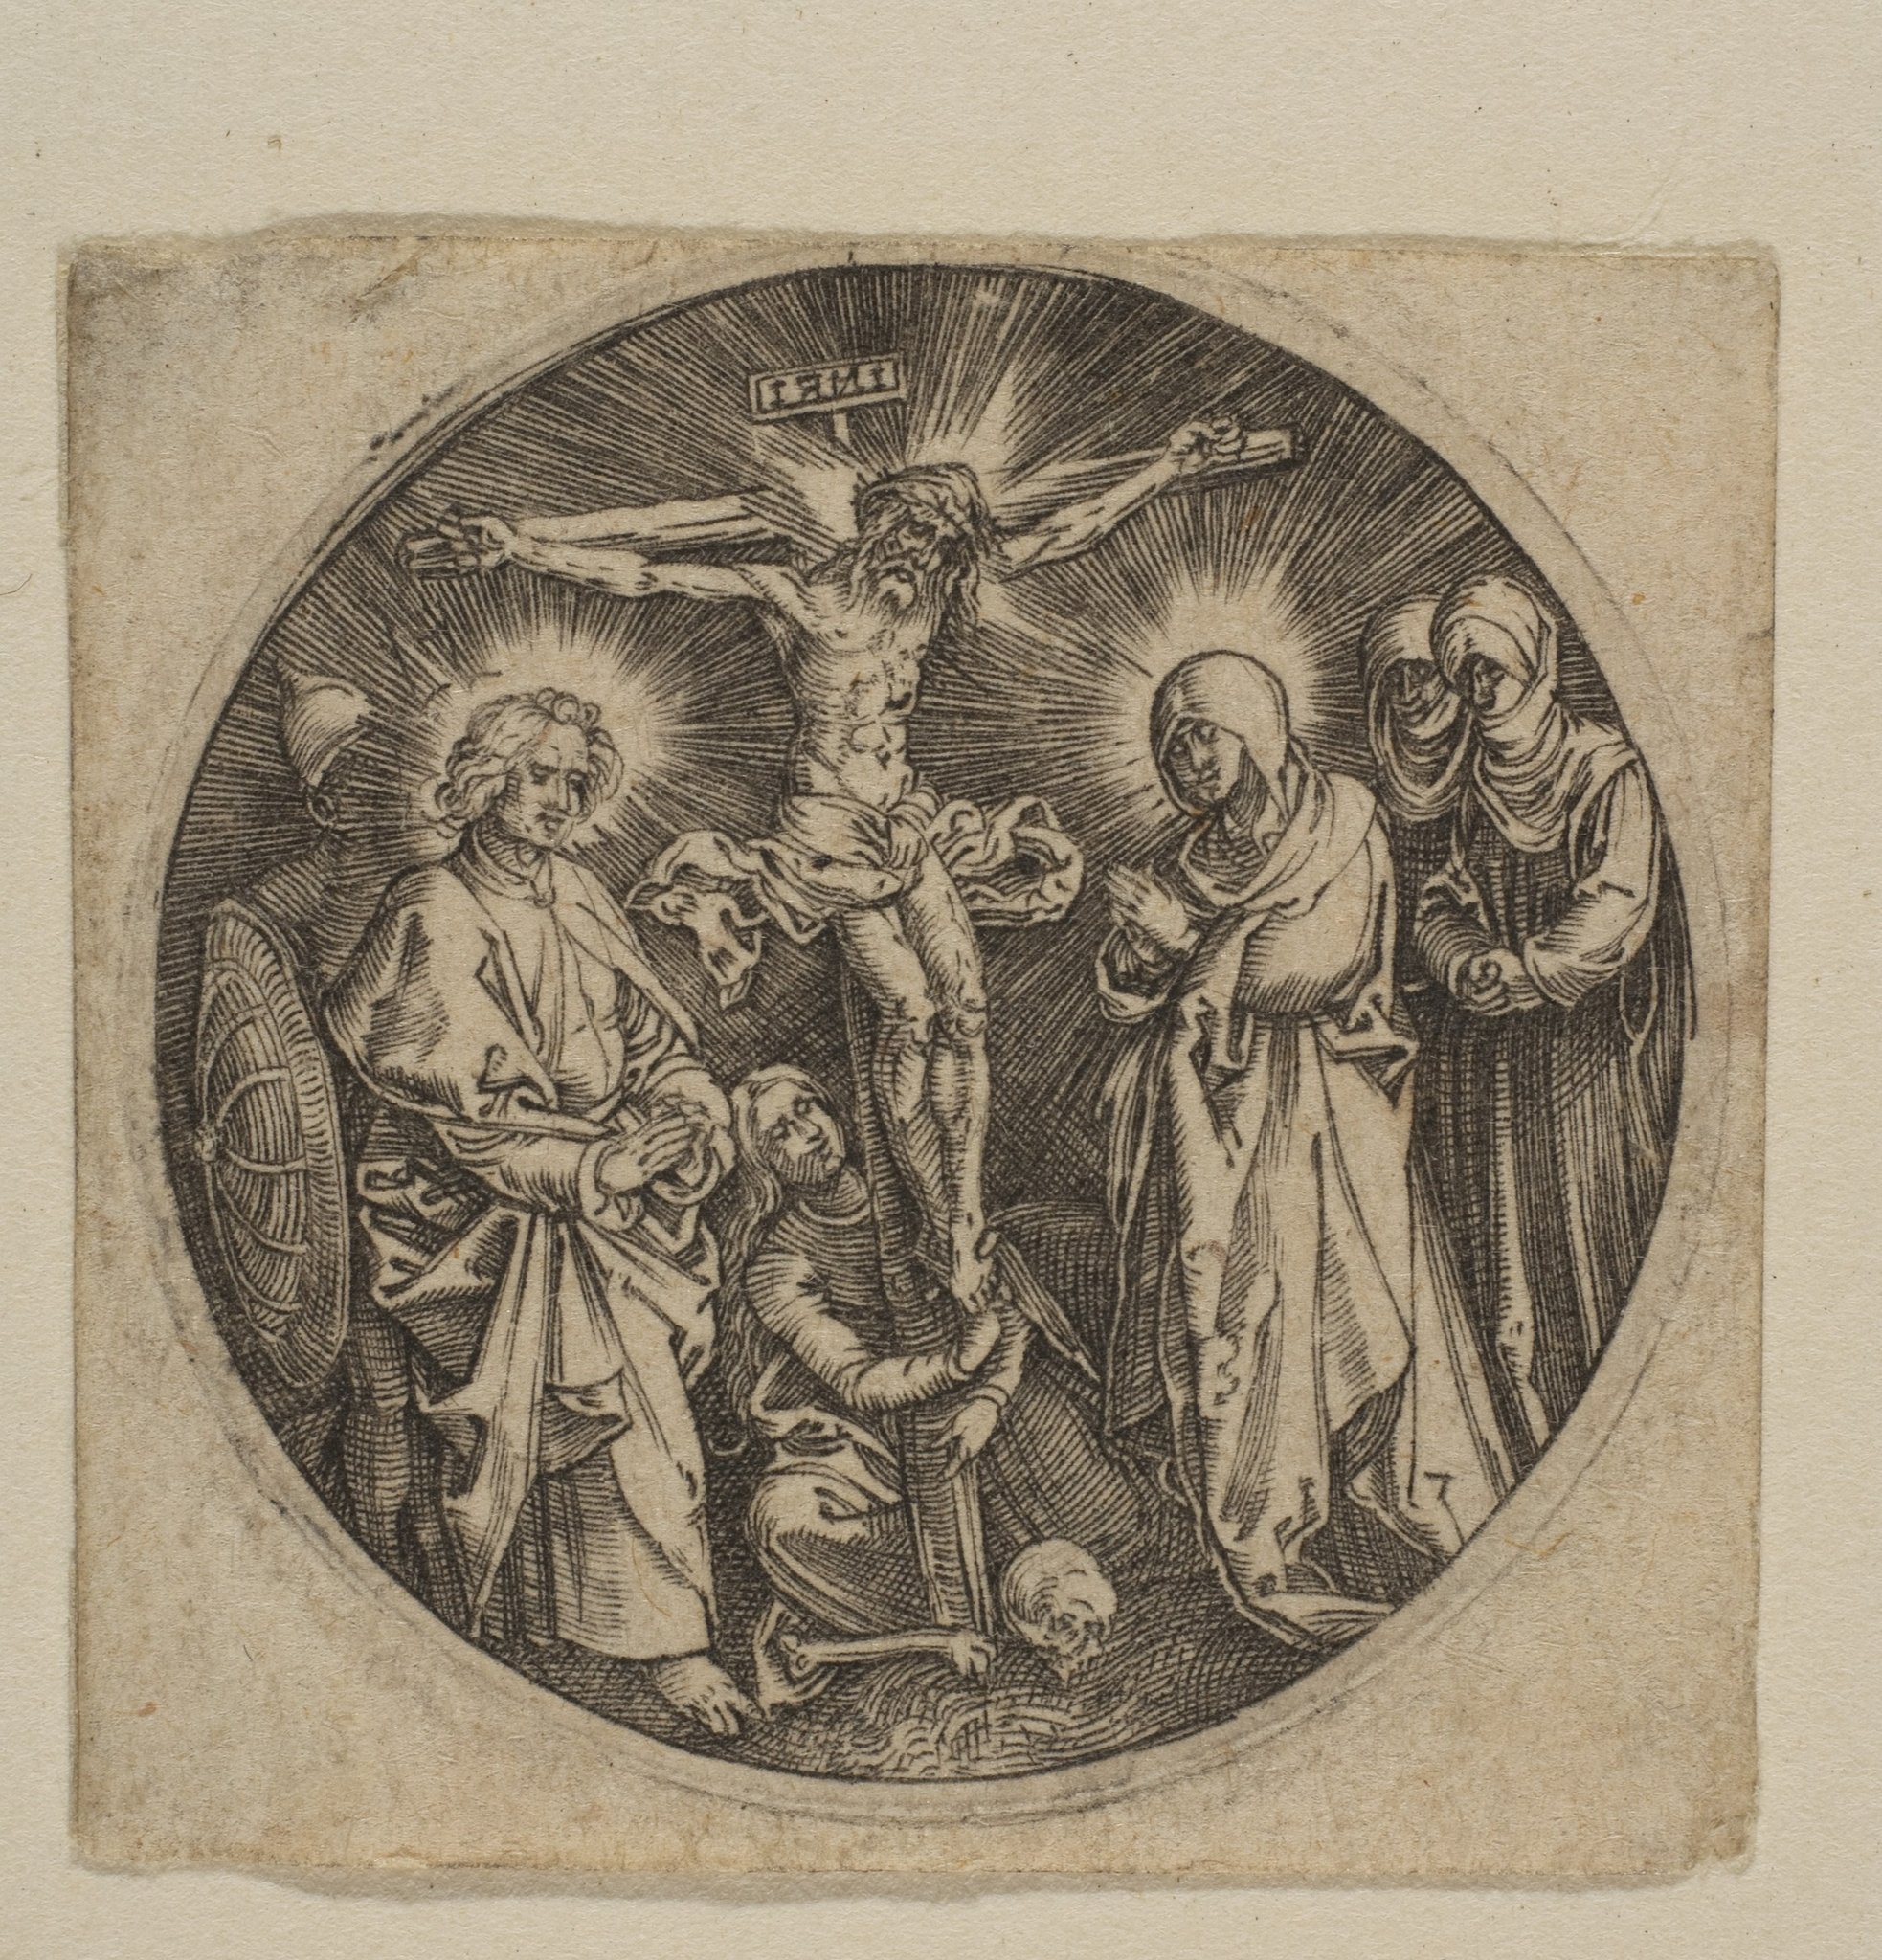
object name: print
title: The Crucifixion (Round)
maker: anonymous, german, 16th century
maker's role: artist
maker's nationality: german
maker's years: 1500-1600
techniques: engraving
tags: christ,crucifixion